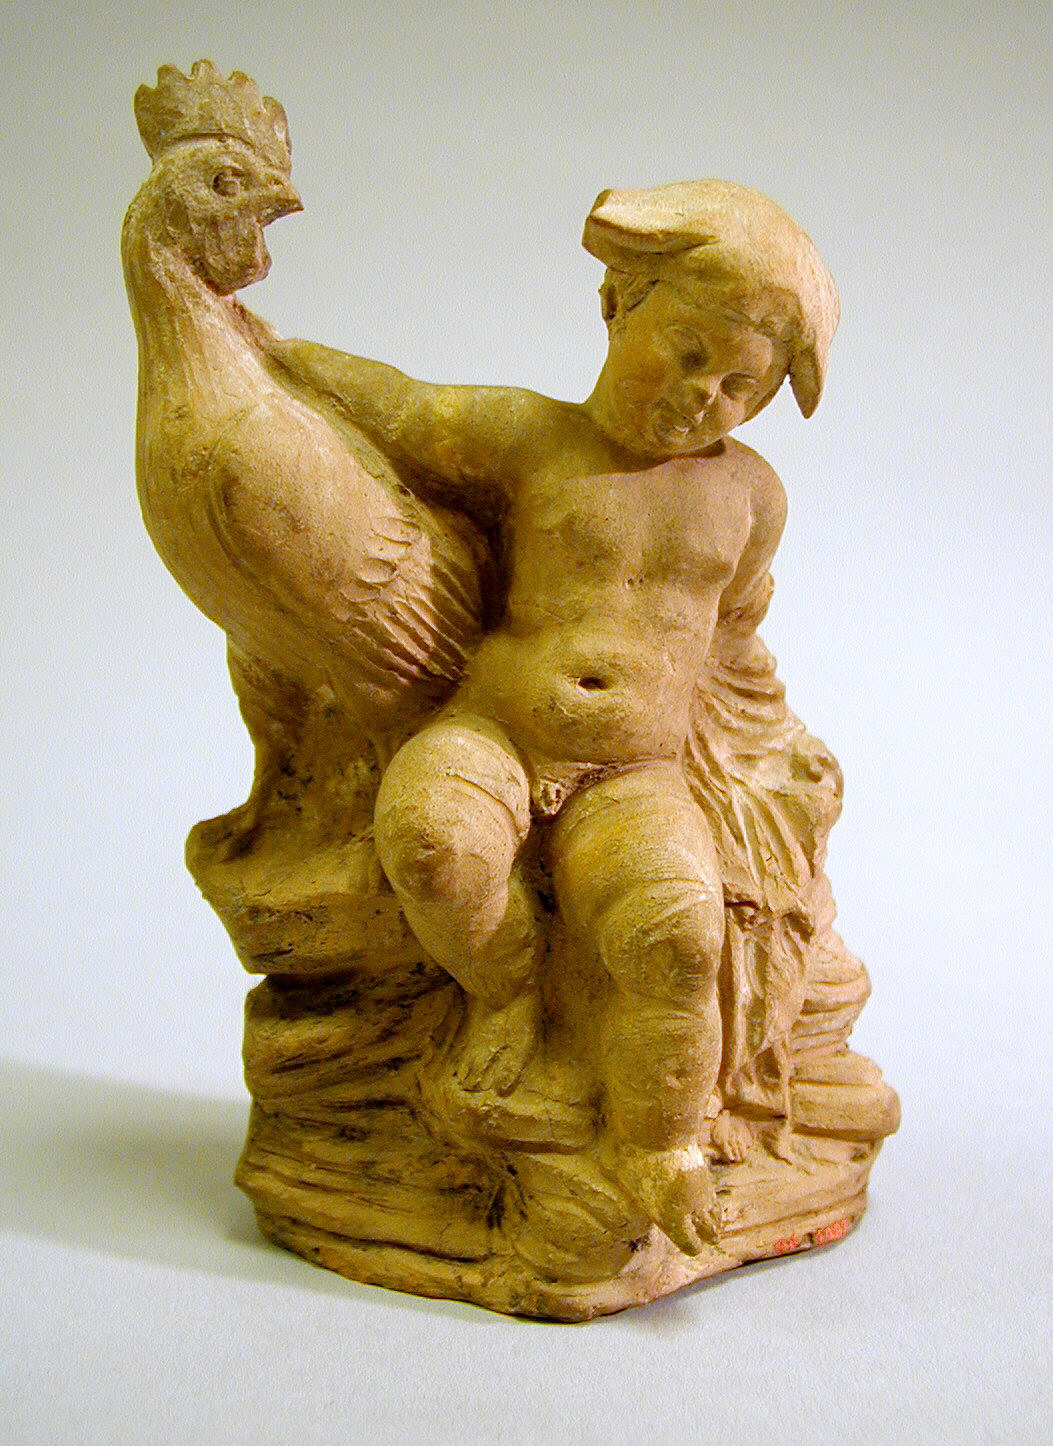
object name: statuette of a boy and rooster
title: Terracotta statuette of a boy and a rooster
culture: greek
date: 200-101 BCE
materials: terracotta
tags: boys,roosters